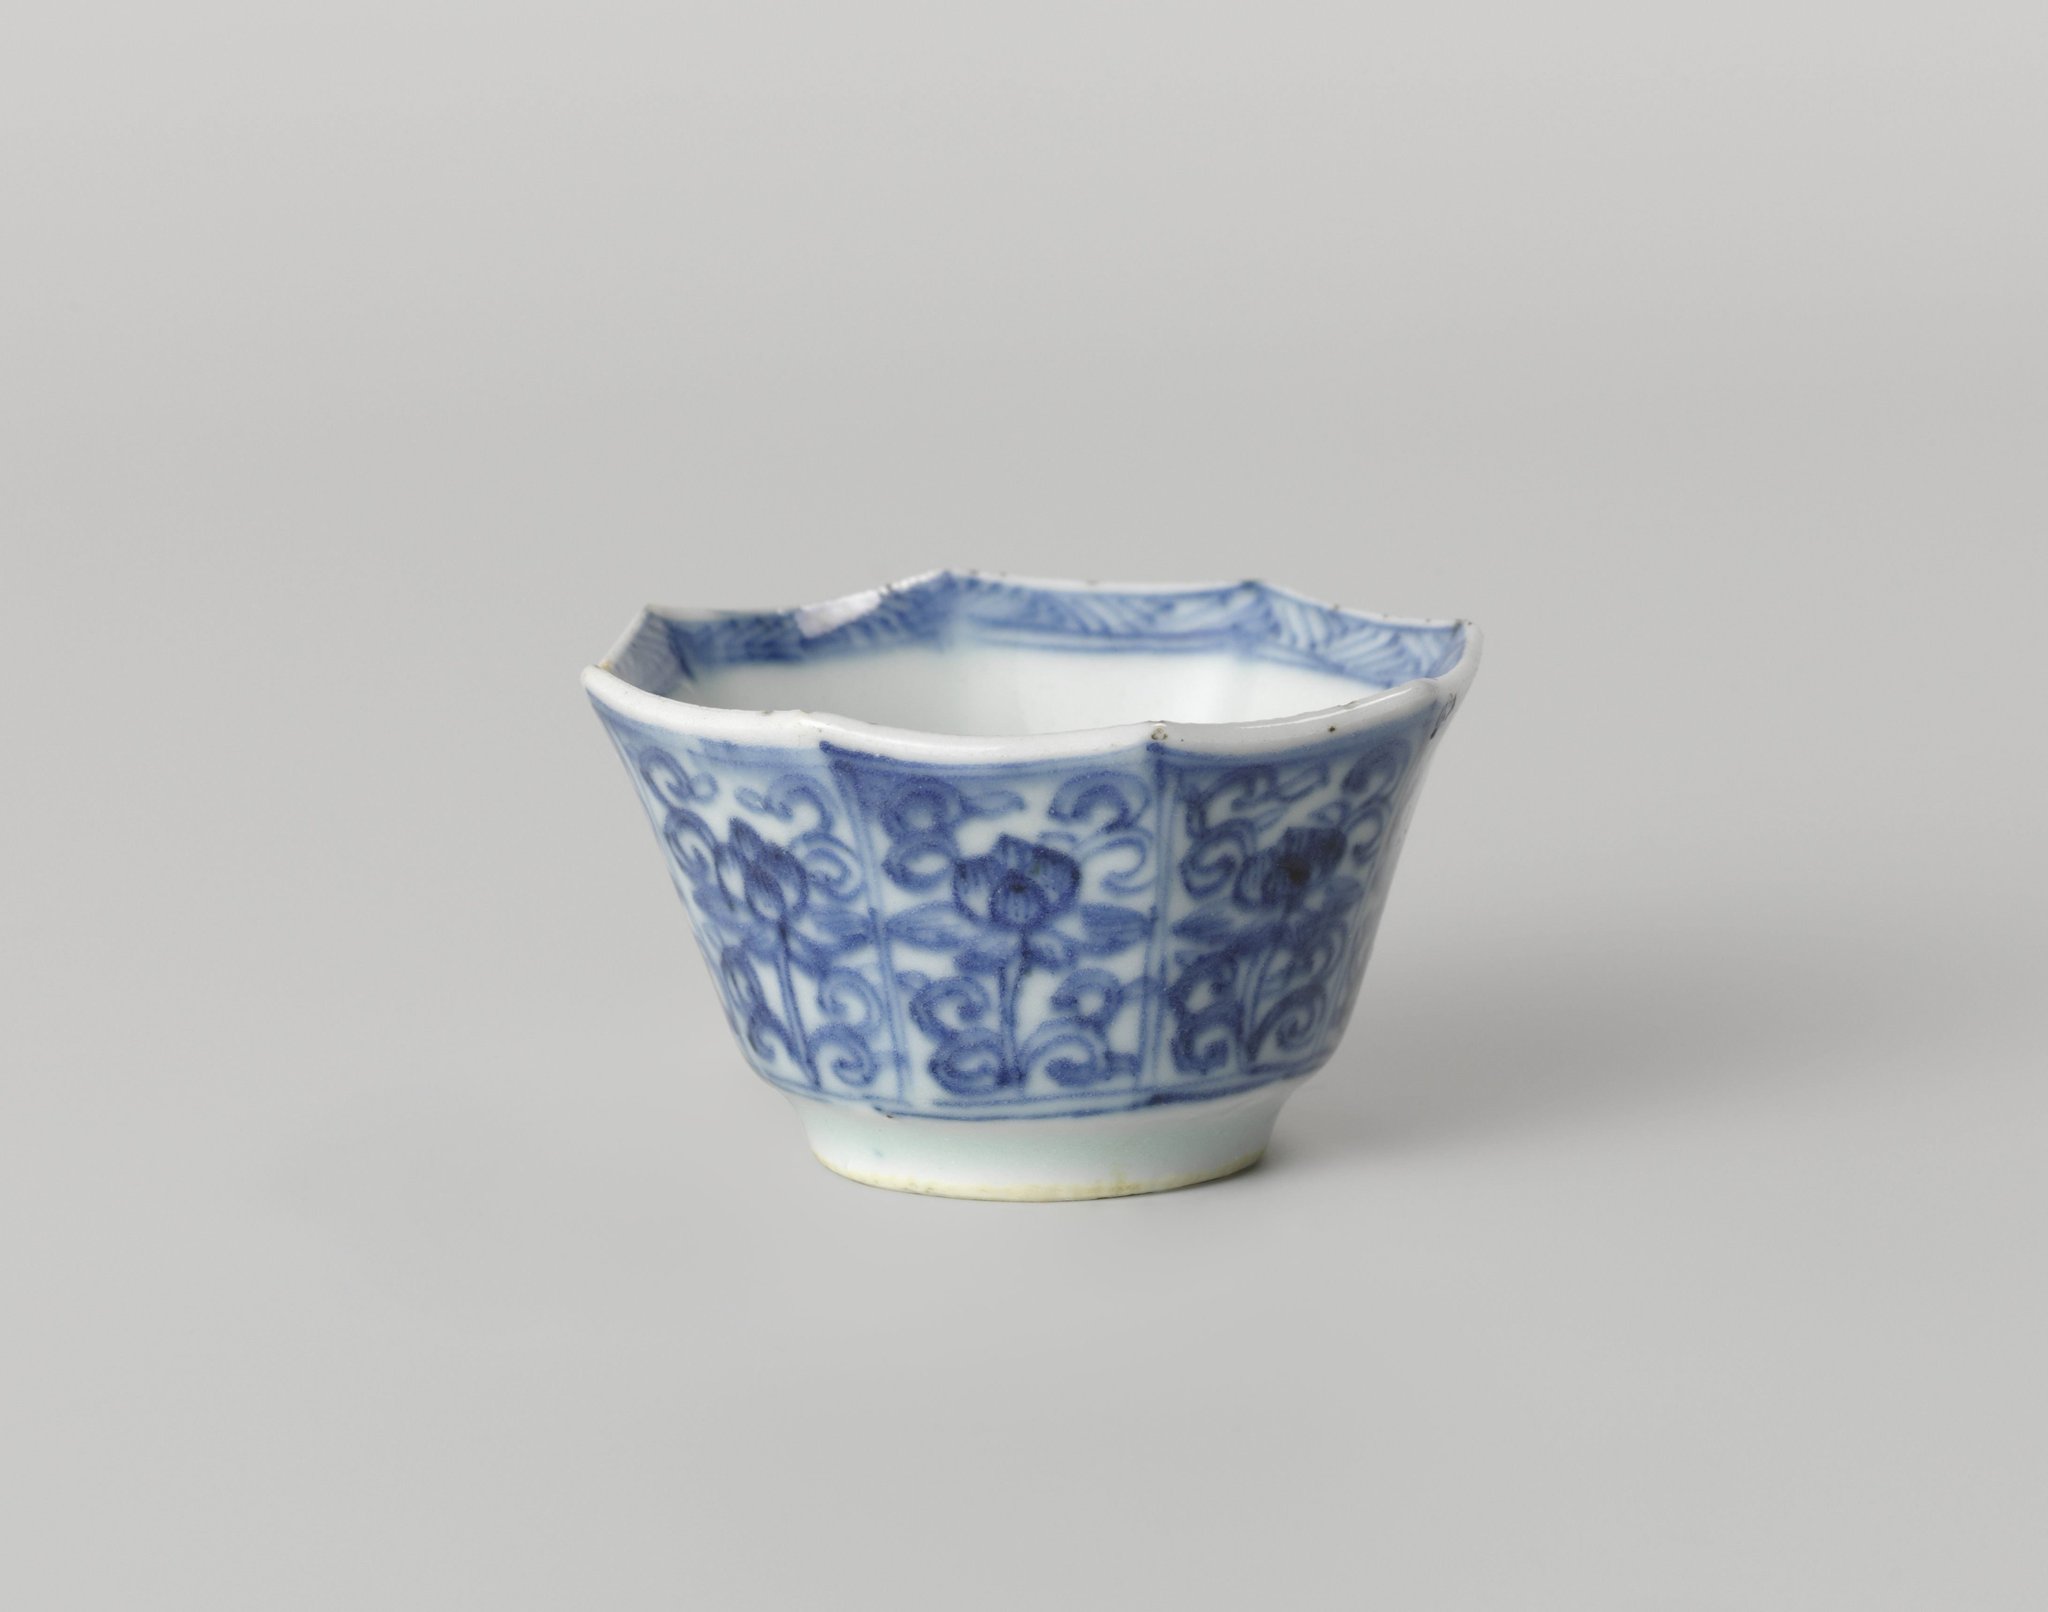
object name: cup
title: Octagonal cup with flower scrolls in panel decoration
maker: Anonymous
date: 1700-1724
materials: cobalt, glaze, paint, porcelain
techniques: firing, forming, turning, vitrification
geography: china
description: Kop van porselein, achtkantig, zonder oor. Beschilderd in onderglazuurblauw met een symmetrisch decor van een bloem en voluuttakken, dat zich op elk vak herhaalt. Langs de binnenzijde van de mondrand een geometrische lijst van schuine lijnen. Op de bodem een achthoek, waarin een bloem.